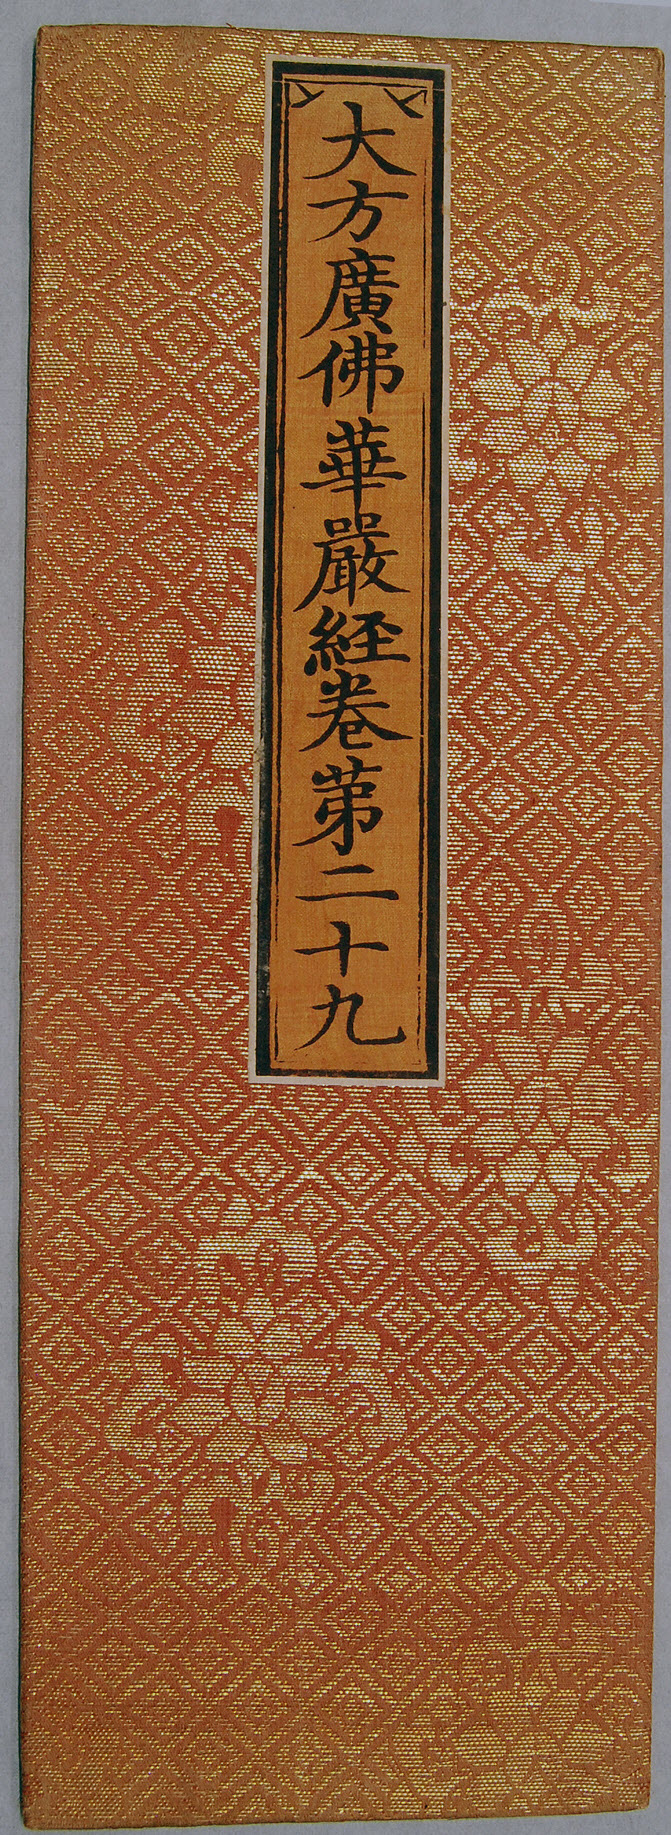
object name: sutra cover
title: Sutra Cover with Pattern of Lotus Motifs on a Background of Nested Diamonds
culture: chinese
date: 1501-1600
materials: metal thread, silk